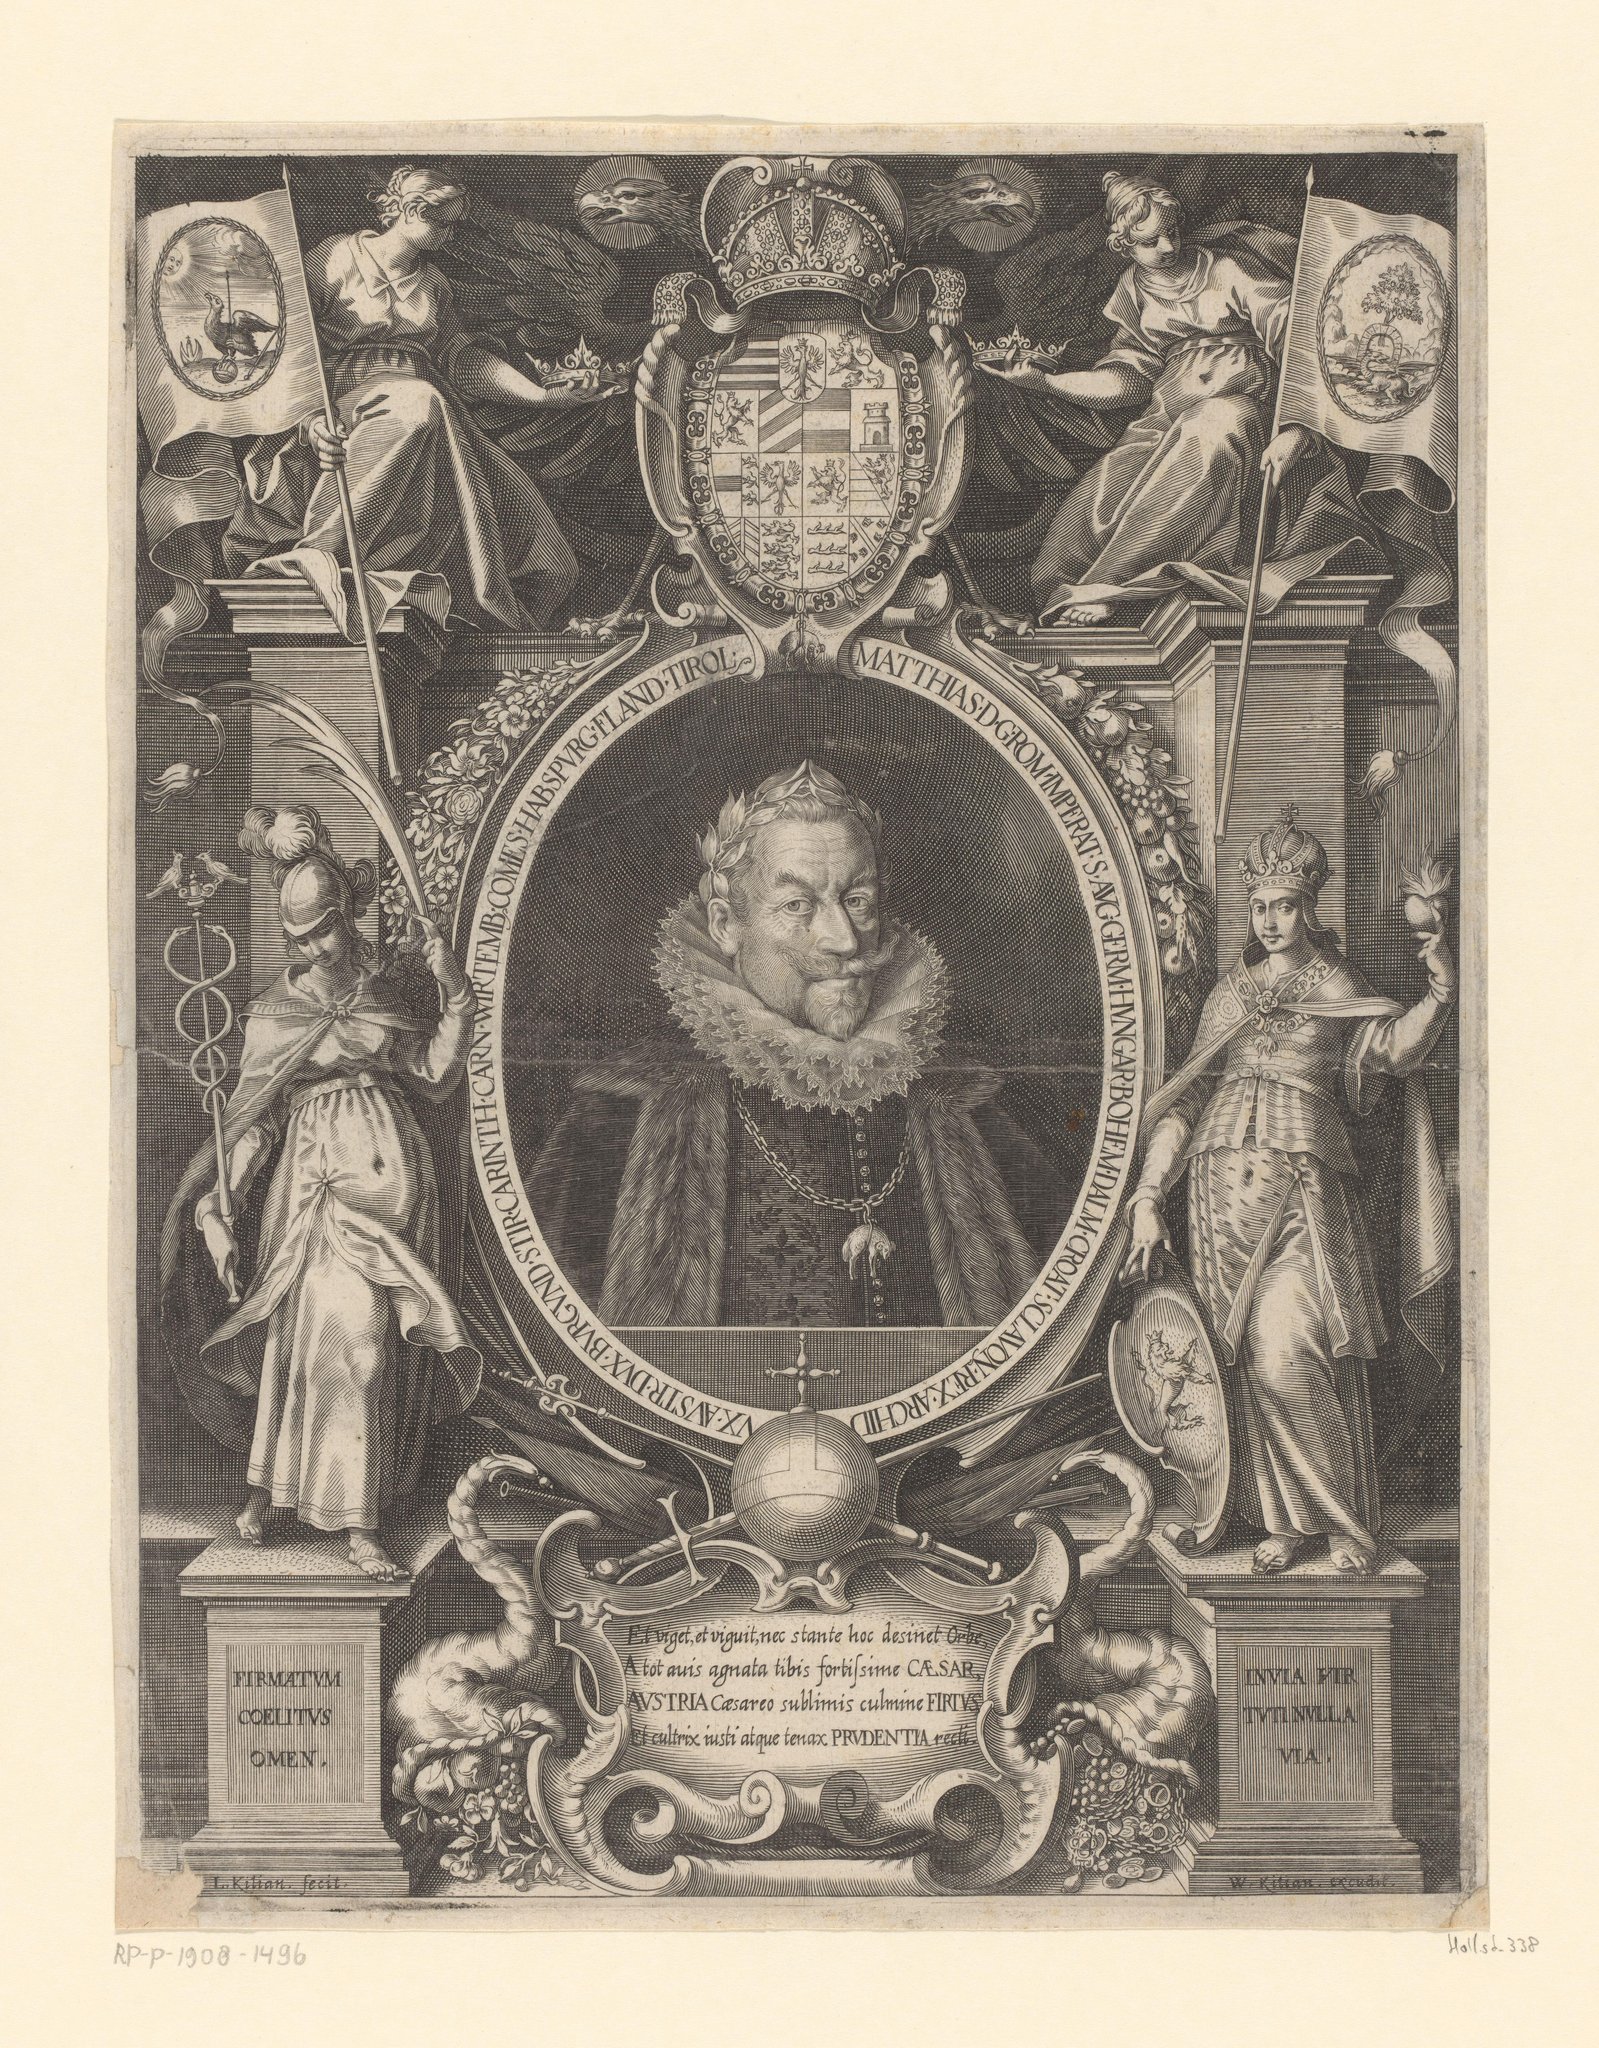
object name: print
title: Portret van keizer Matthias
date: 1612-1637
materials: paper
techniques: engraving, etching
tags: vienna, matthias van oostenrijk (rooms-duits keizer), 'cornucopia', horn of plenty, historical persons, ruler, sovereign, knighthood order of the golden fleece - insignia of a knighthood order, e.g.: badge, chain (with name of order), allegory, personification of good government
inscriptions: collector's mark: Lugt 2228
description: Een allegorie op goede heerschappij. Tekst in het Latijn in de omlijsting, op de sokkels en in de cartouche.